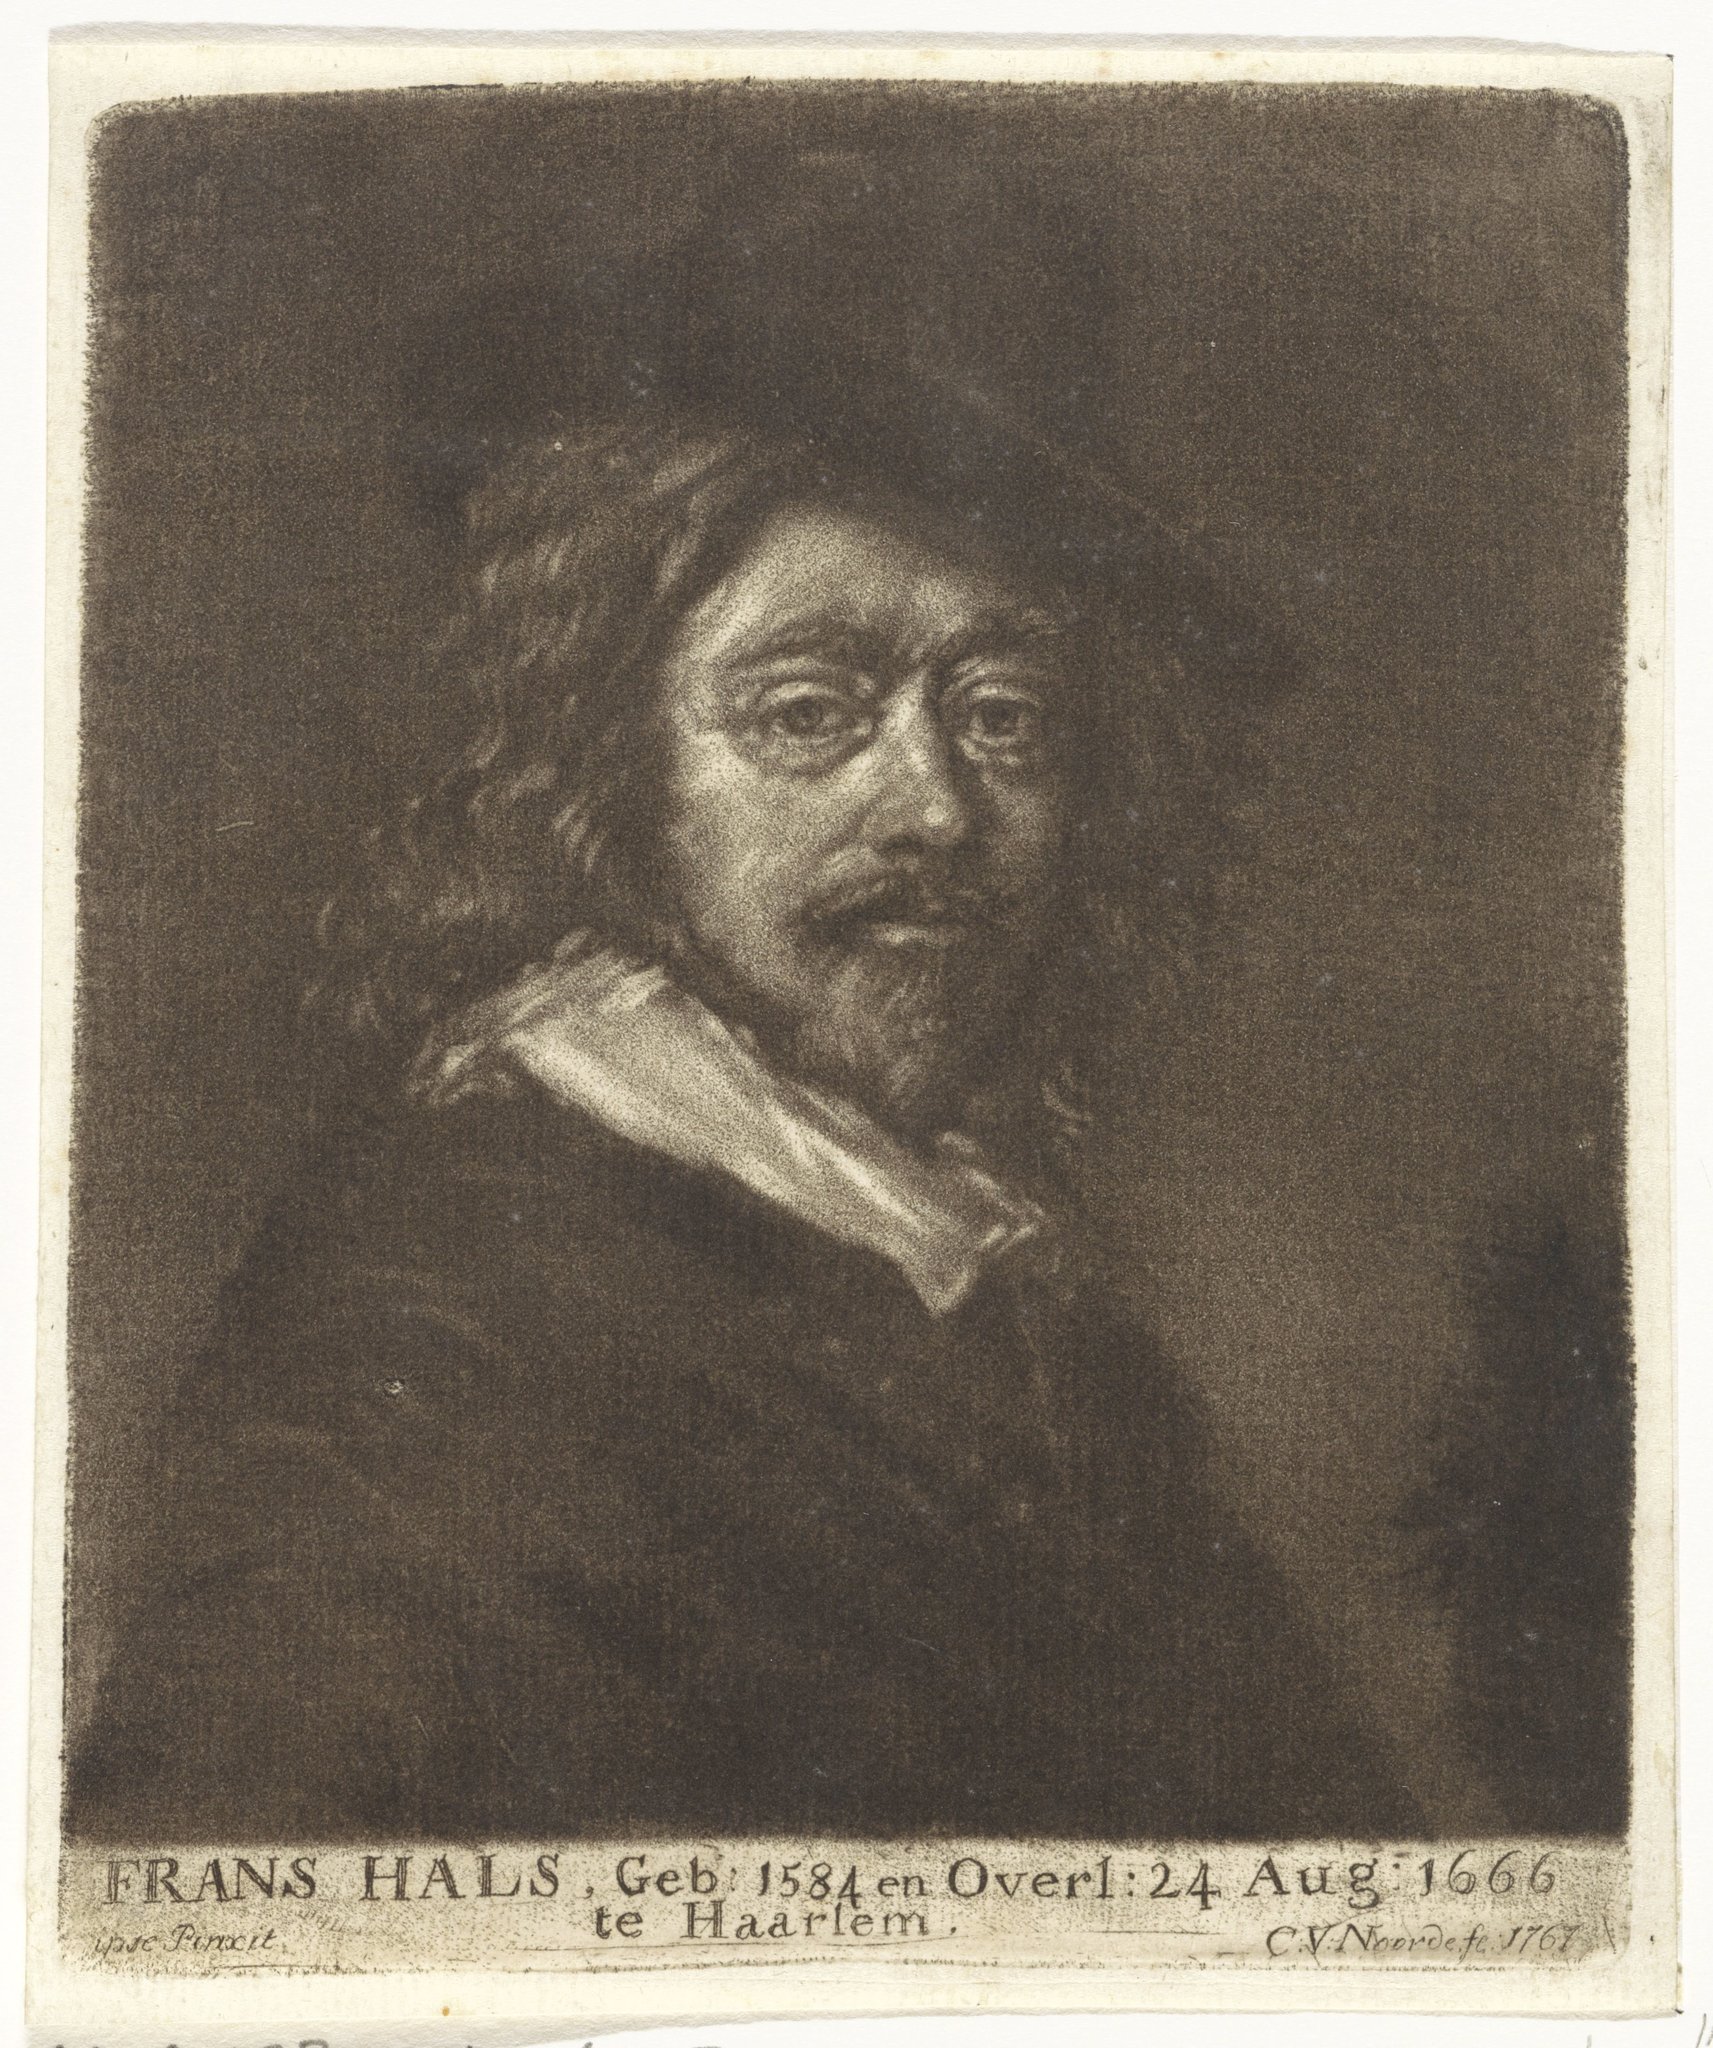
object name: print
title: Portret van Frans Hals met een hoed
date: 1767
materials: paper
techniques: engraving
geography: haarlem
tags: antwerp, haarlem, draughtsman, frans hals, head-gear: hat (+ men's clothes)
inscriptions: collector's mark: Lugt 2228